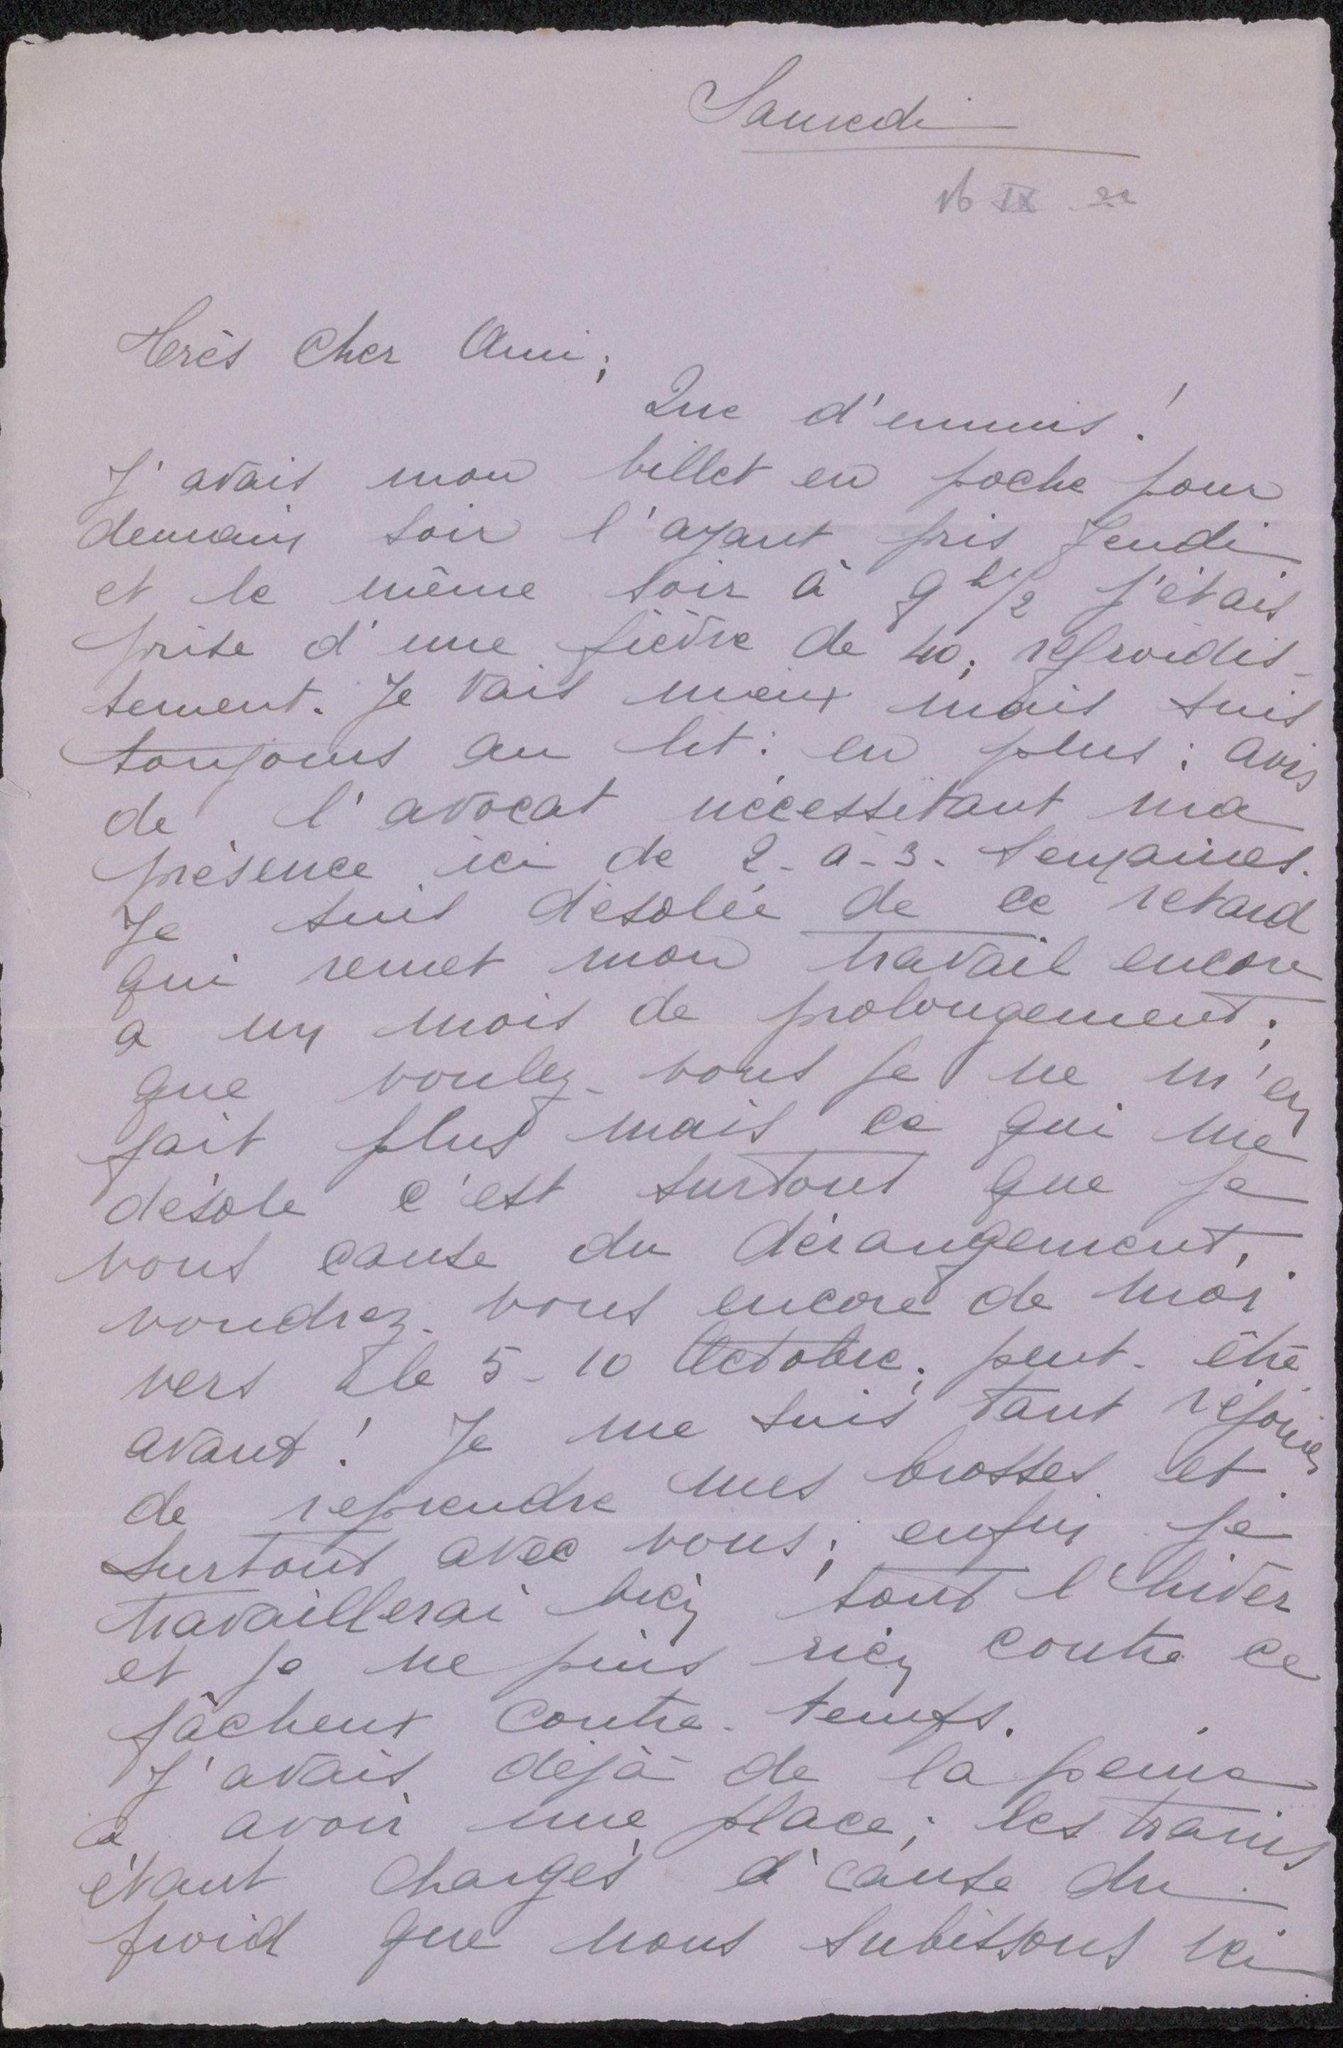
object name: letter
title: Brief aan Philip Zilcken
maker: rose imel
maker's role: draughtsman, painter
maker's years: 1901-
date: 1911-1930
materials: ink, paper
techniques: pen, writing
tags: painter, draughtsman, philip zilcken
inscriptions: collector's mark: ‘RPK’